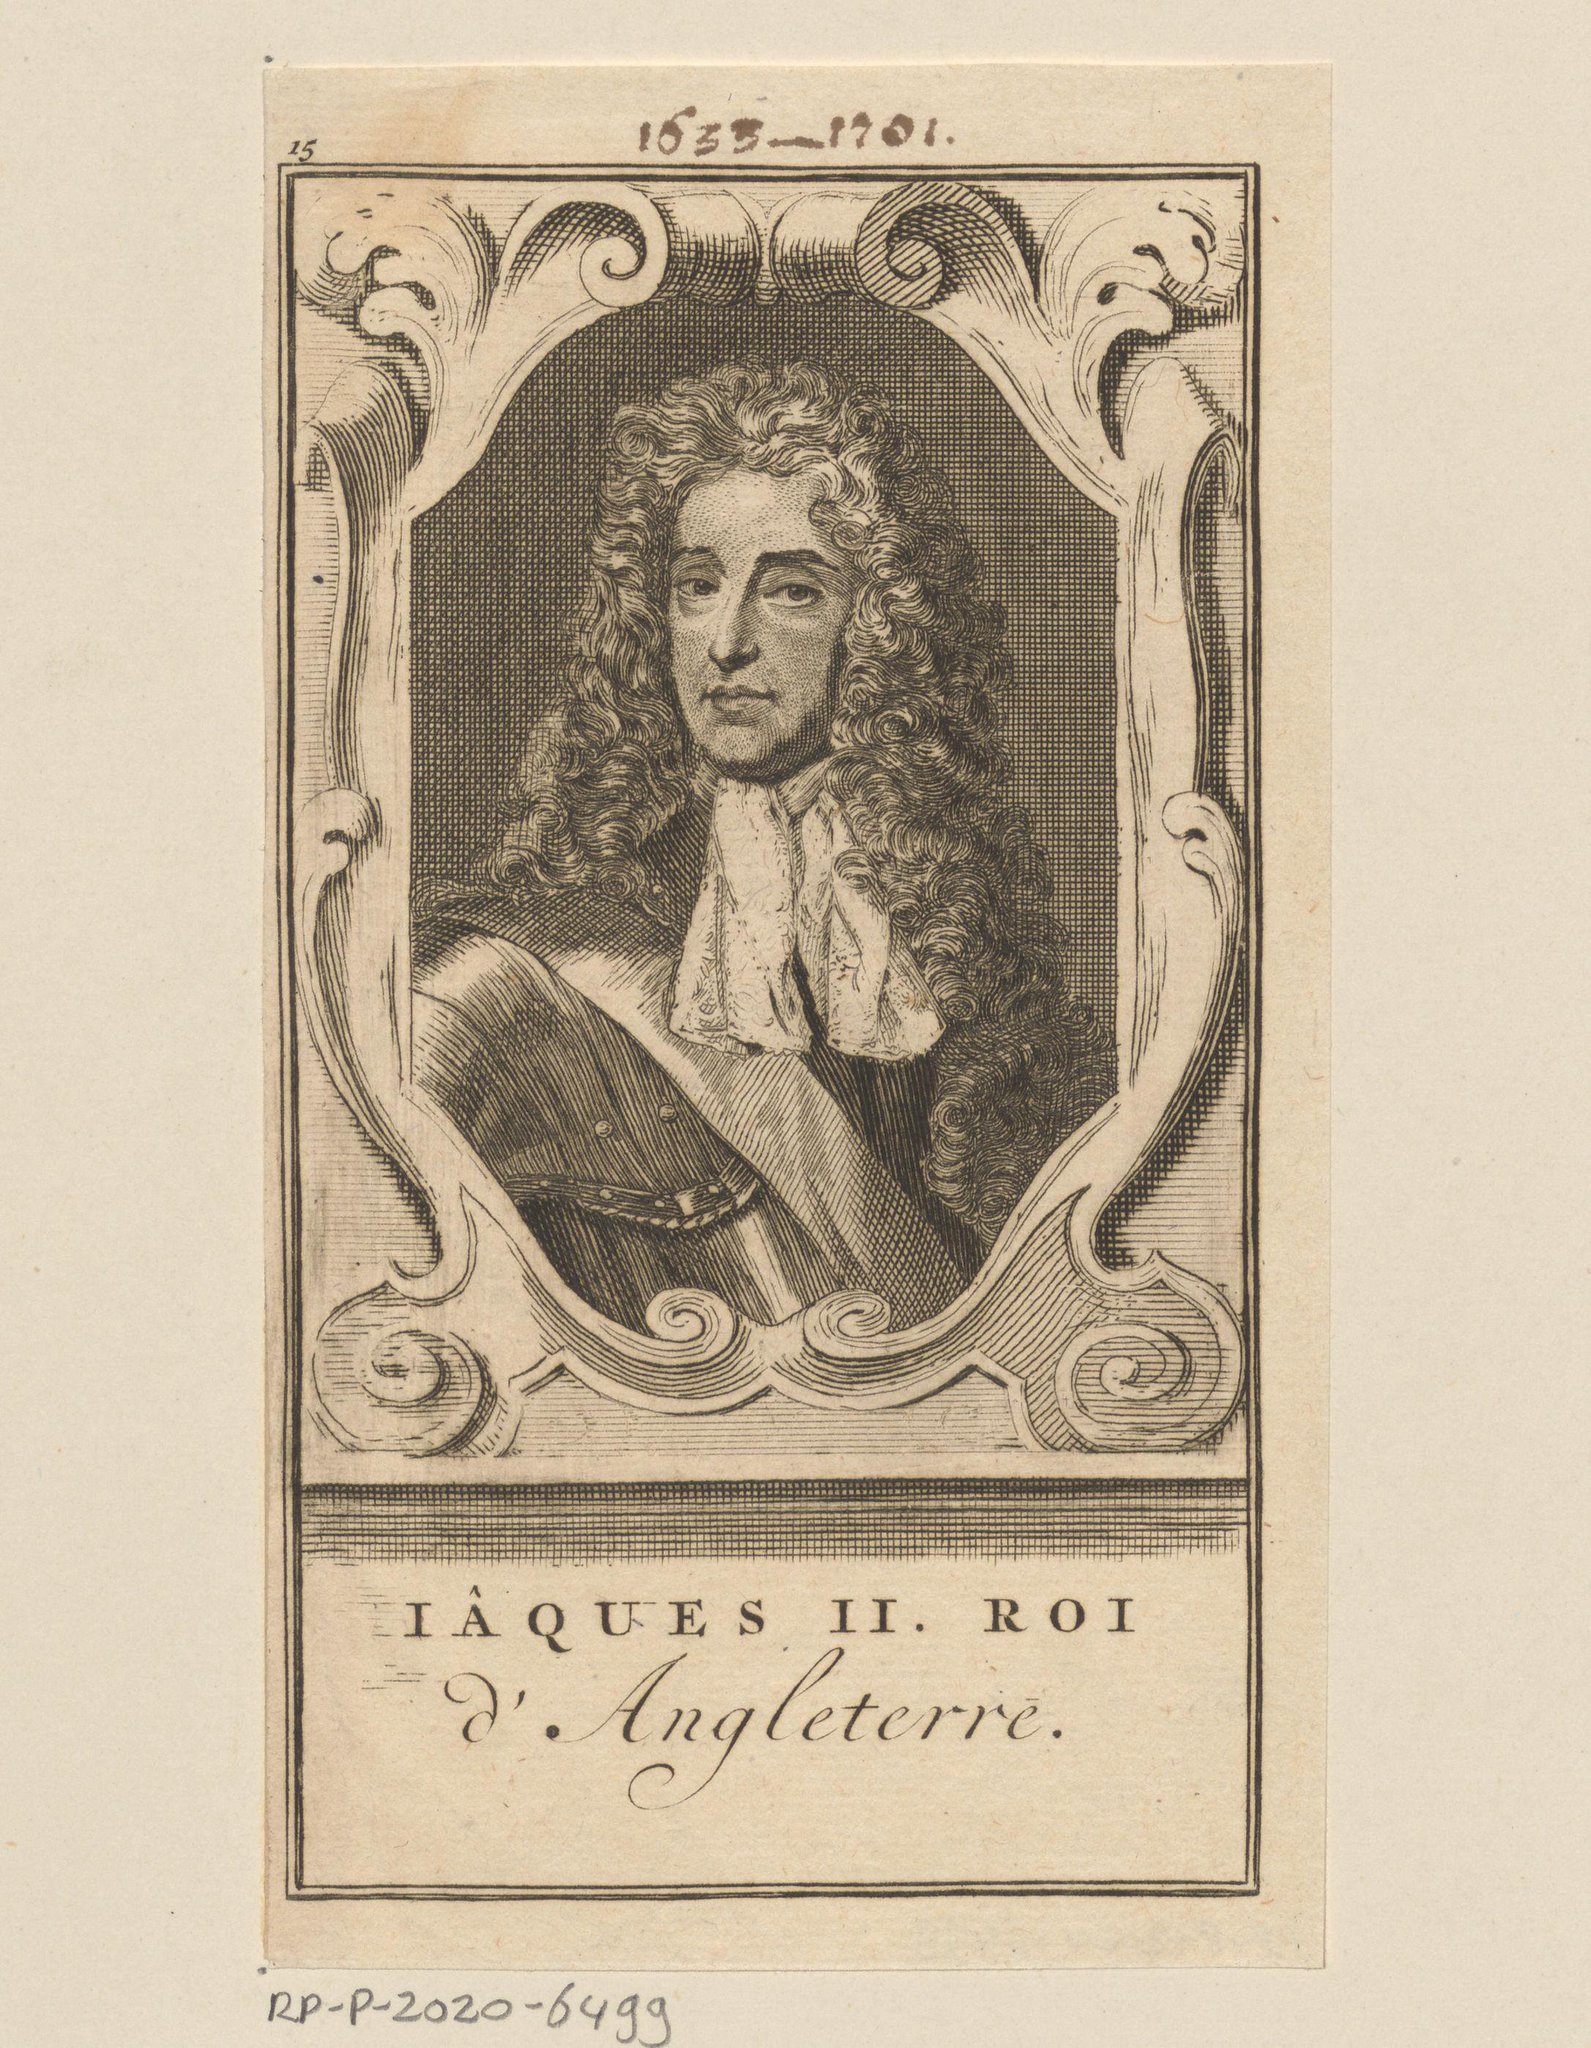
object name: print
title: Portret van Jacobus II, koning van Engeland en Schotland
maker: Anonymous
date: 1685-1750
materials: paper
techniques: engraving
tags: jacobus ii (koning van engeland en schotland), historical persons, king